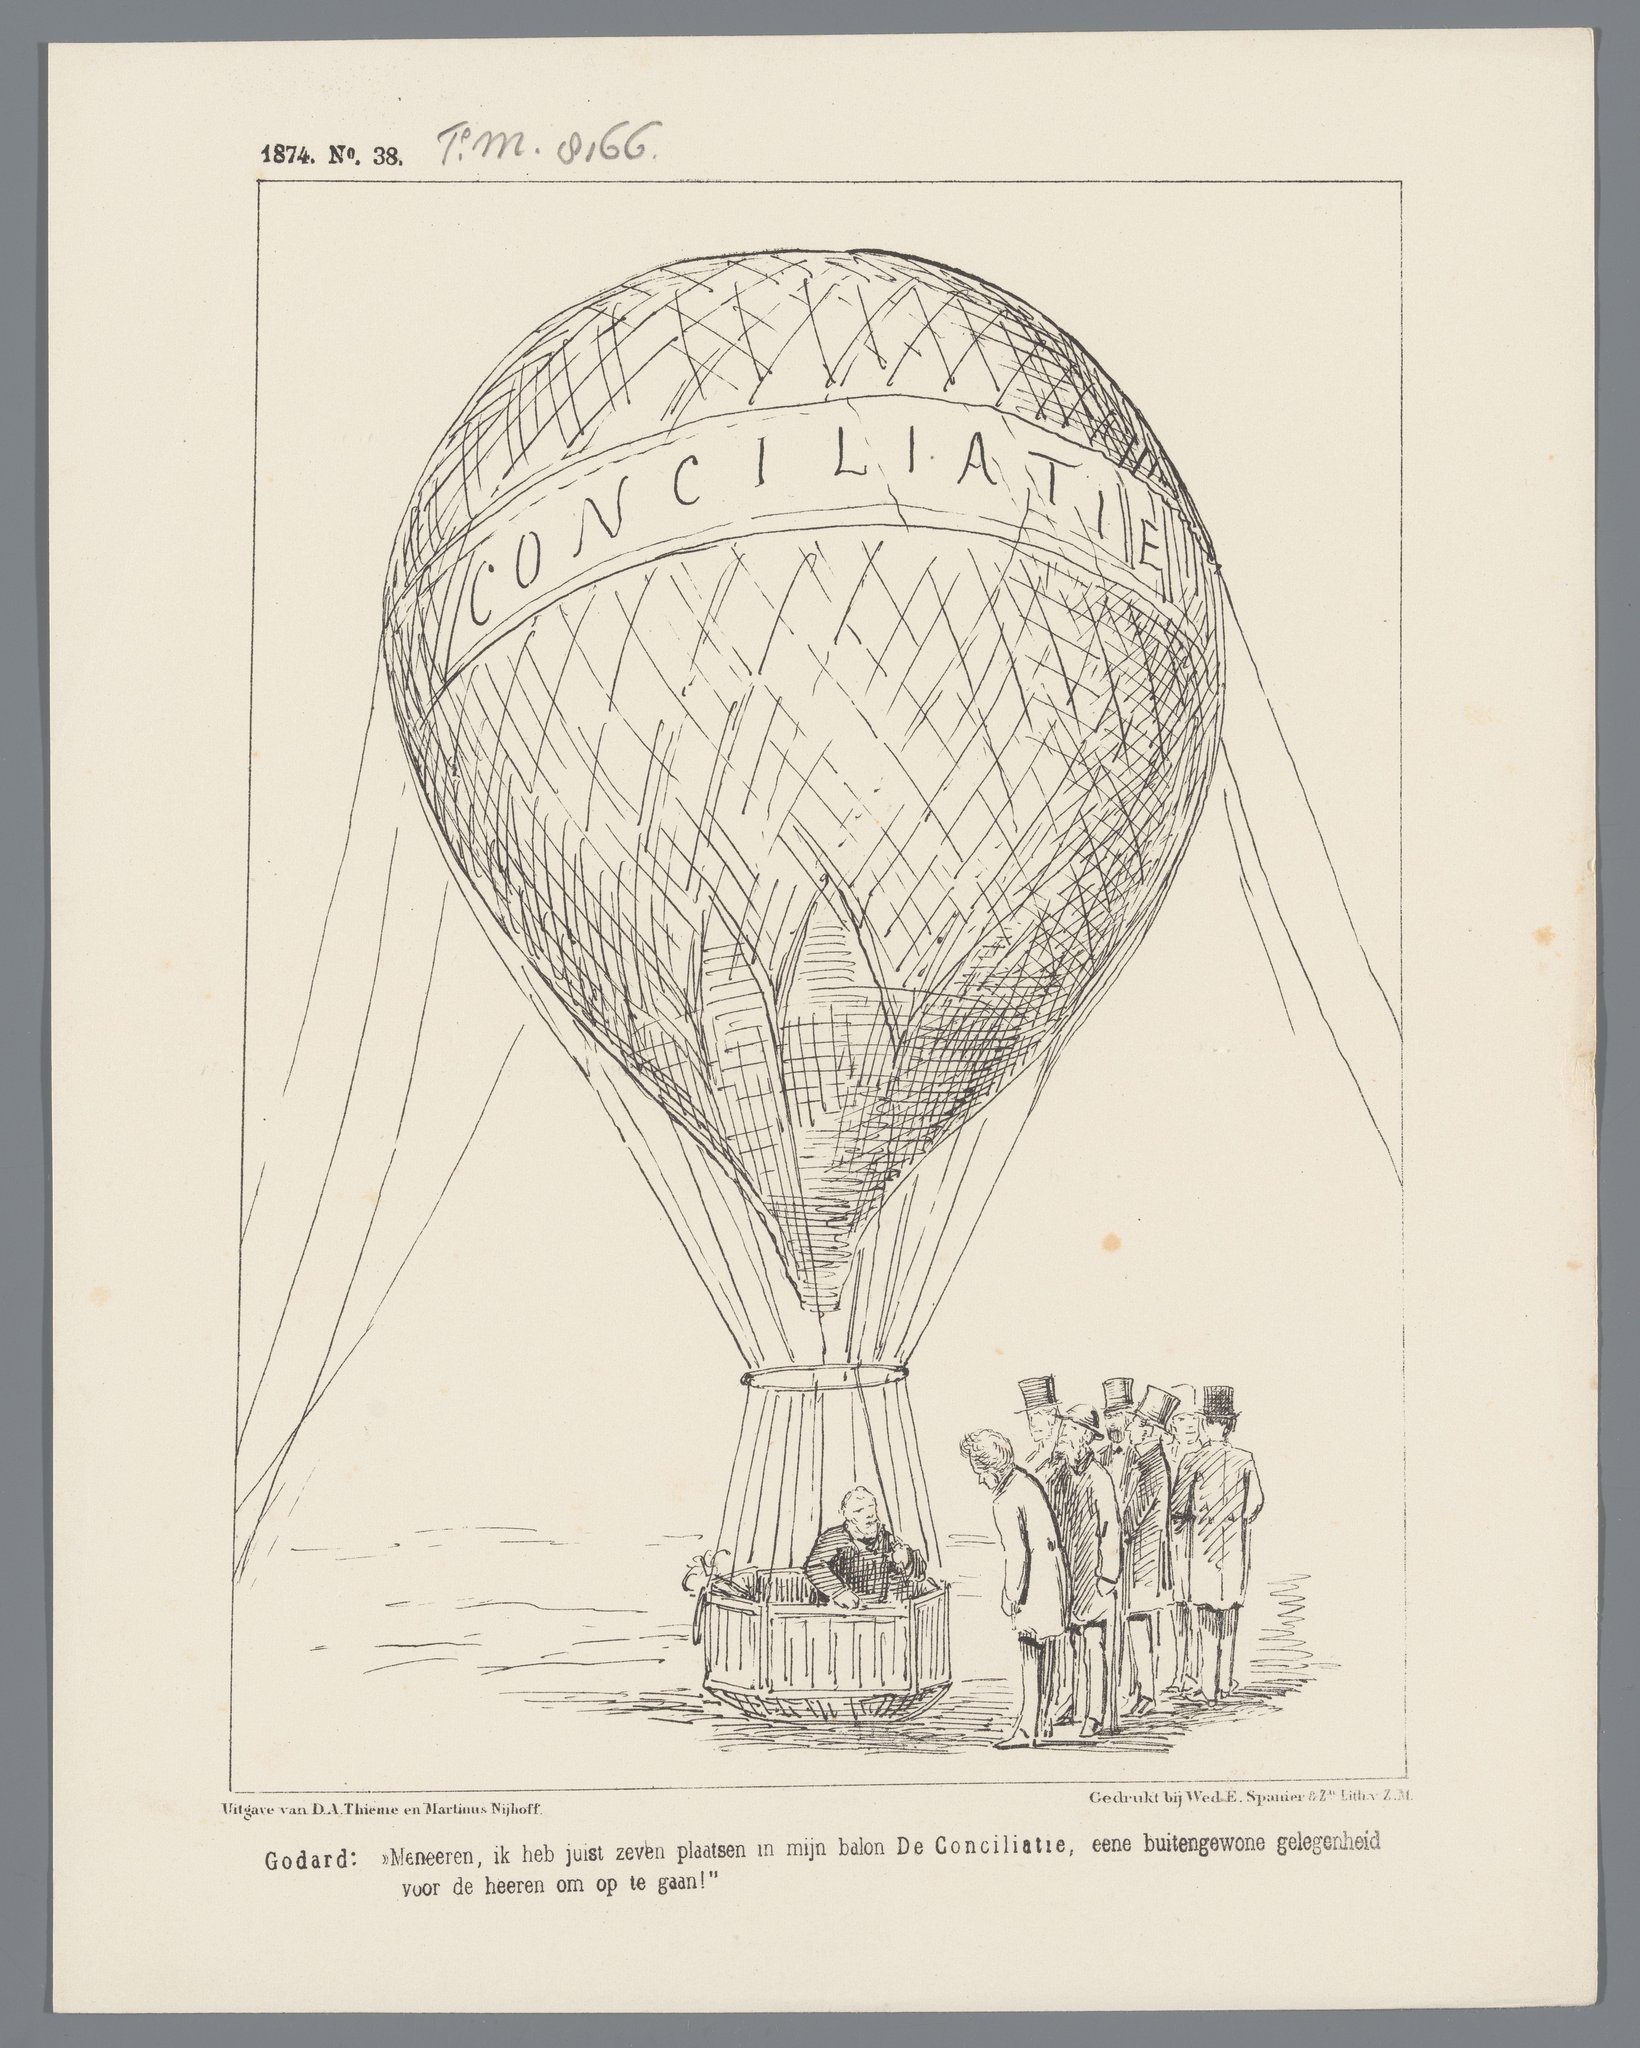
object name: cartoon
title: Spotprent waarin de ballonvaarder Godard met ministerie Heemskerk uitnodigt om mee te varen in zijn ballon 'Conciliatie', 1874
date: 1874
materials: paper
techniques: lithograph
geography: the hague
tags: balloon (aviation)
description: Spotprent waarin de Franse ballonvaarder Eugène Godard met ministerie Heemskerk uitnodigt om mee te varen in zijn ballon 'Conciliatie', 1874. Plaat verschenen bij het weekblad De Nederlandsche Spectator, nr. 38, 1874.